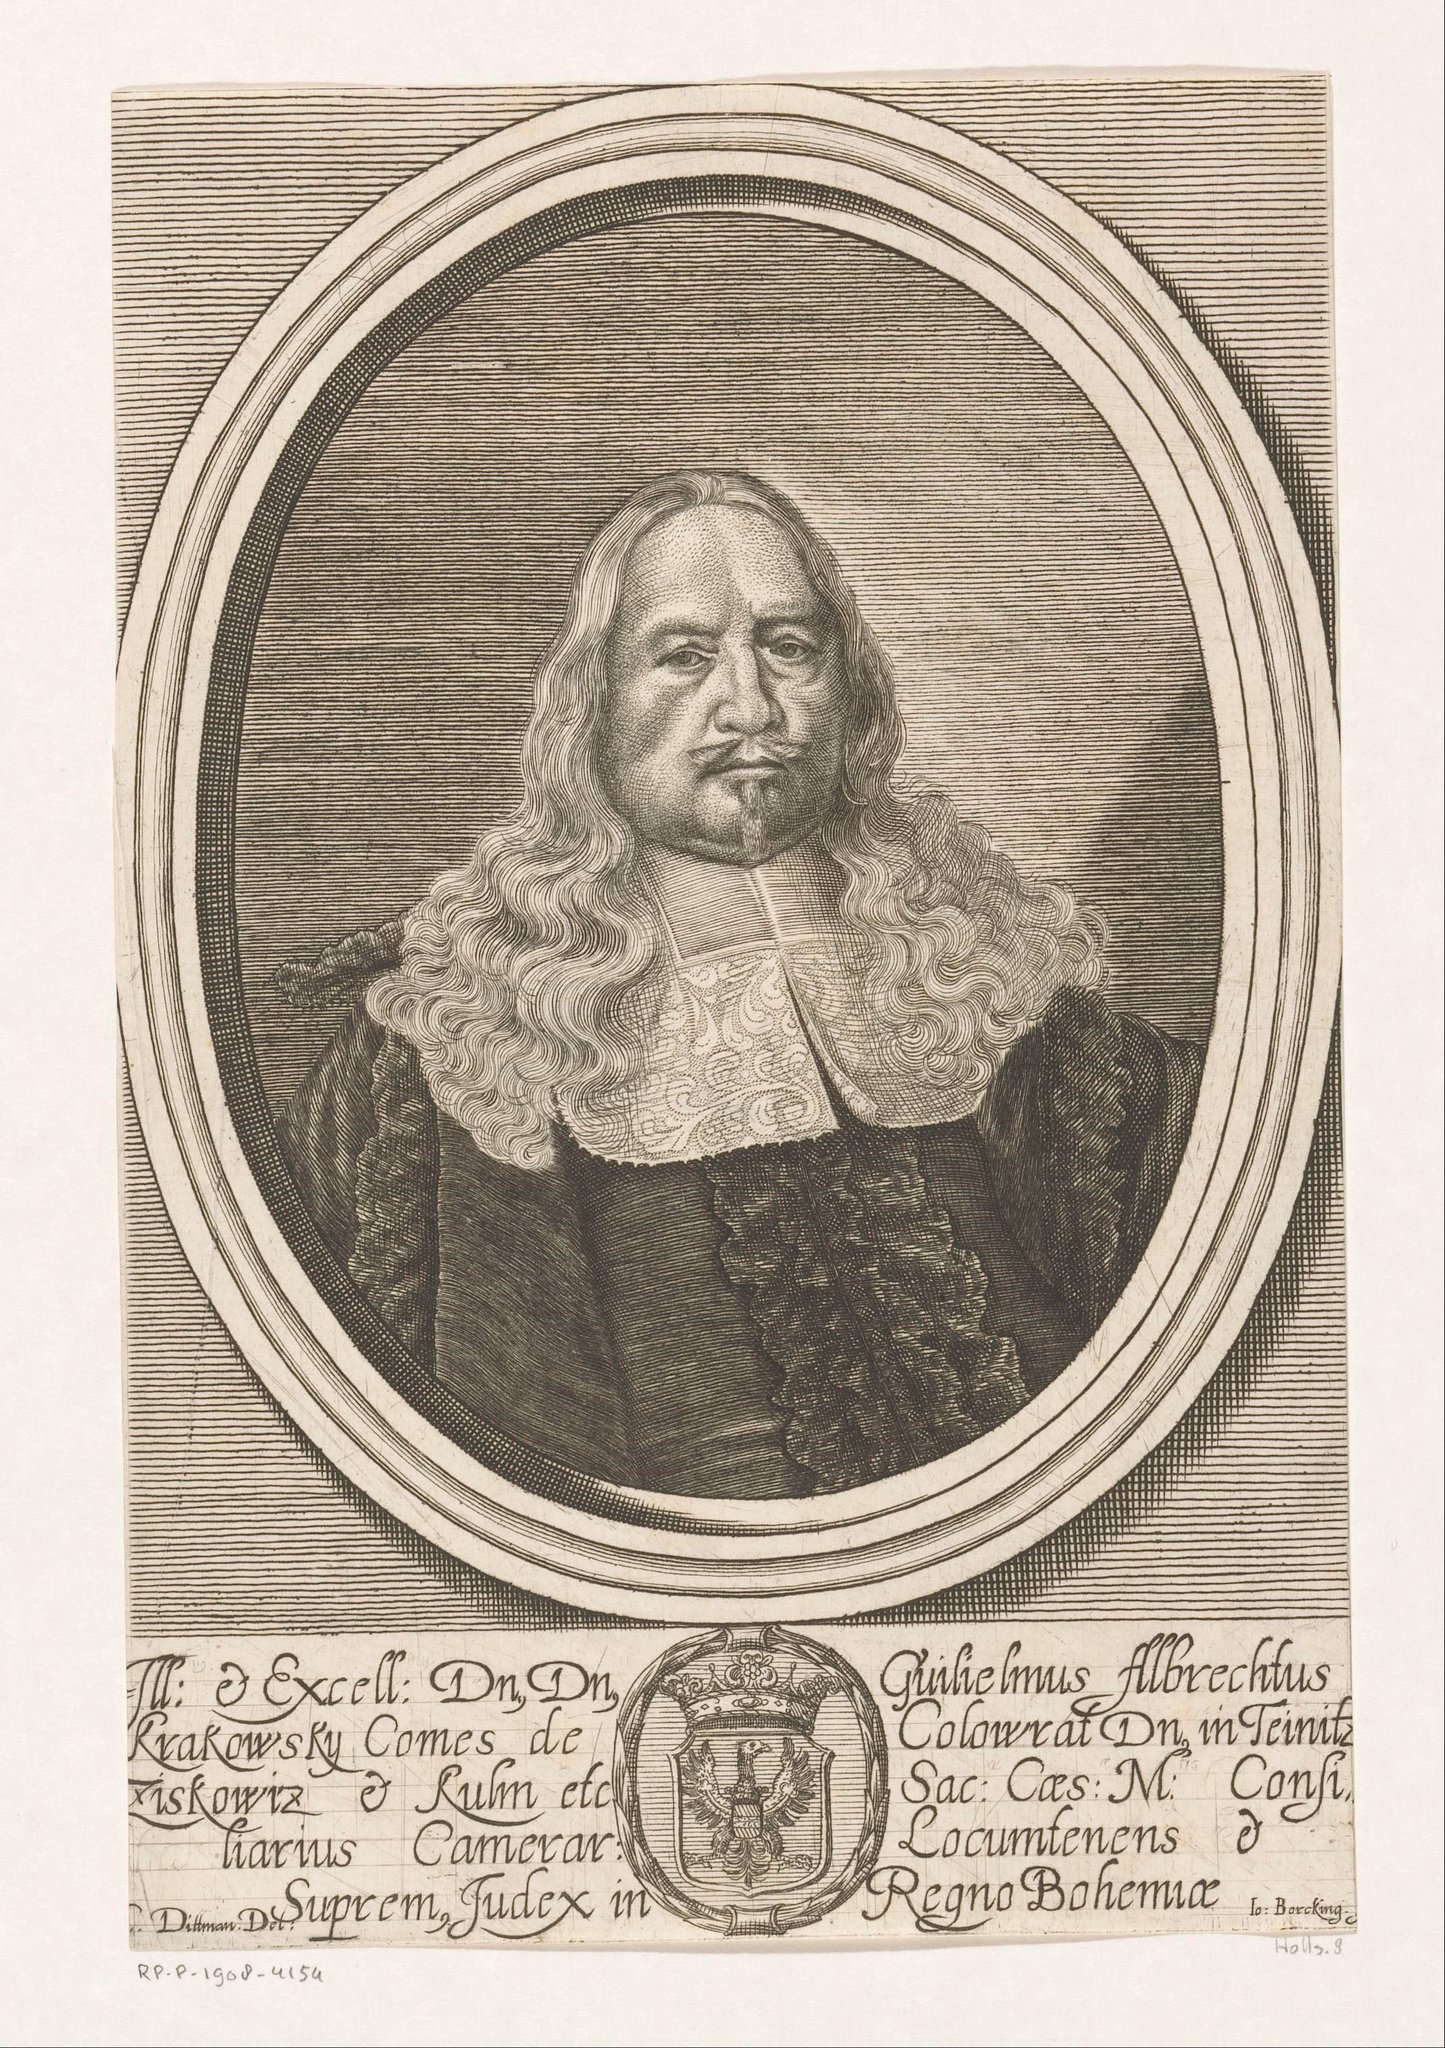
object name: print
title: Portret van Wilhelm Albrecht, Reichsgraf von Kolowrat-Krakowsky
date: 1673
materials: paper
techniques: engraving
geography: prague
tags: historical persons, armorial bearing, heraldry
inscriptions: collector's mark: Lugt 2228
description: Prent ook gebruikt in: Weingarten, Johann Jacob von. Fürsten-Spiegel oder Monachia deß höchlöblichen Ertz-Hauses Oesterreich. 2 dln. Praag: [gedrukt door:] Johann Arnold von Dobroslawina, 1673.